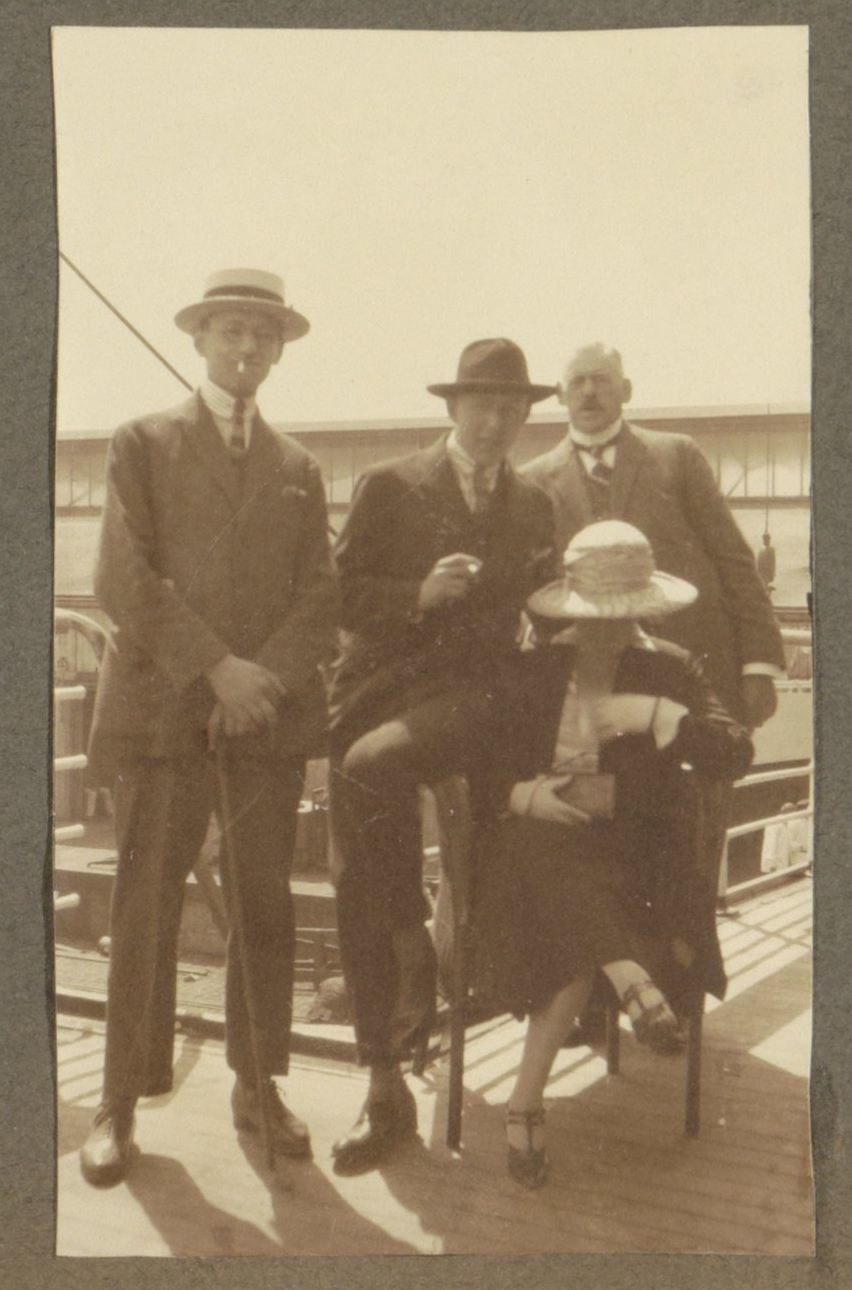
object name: photograph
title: Gezelschap aan boord van de S.S. 'Van Rensselaer'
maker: Anonymous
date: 1906-1924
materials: photographic support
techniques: gelatin silver print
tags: adult woman, adult man, travelling; tourism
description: Onderdeel van fotoalbum van een onbekende Nederlandse familie met opnames van Suriname, Europa en Nederlands-Indië.